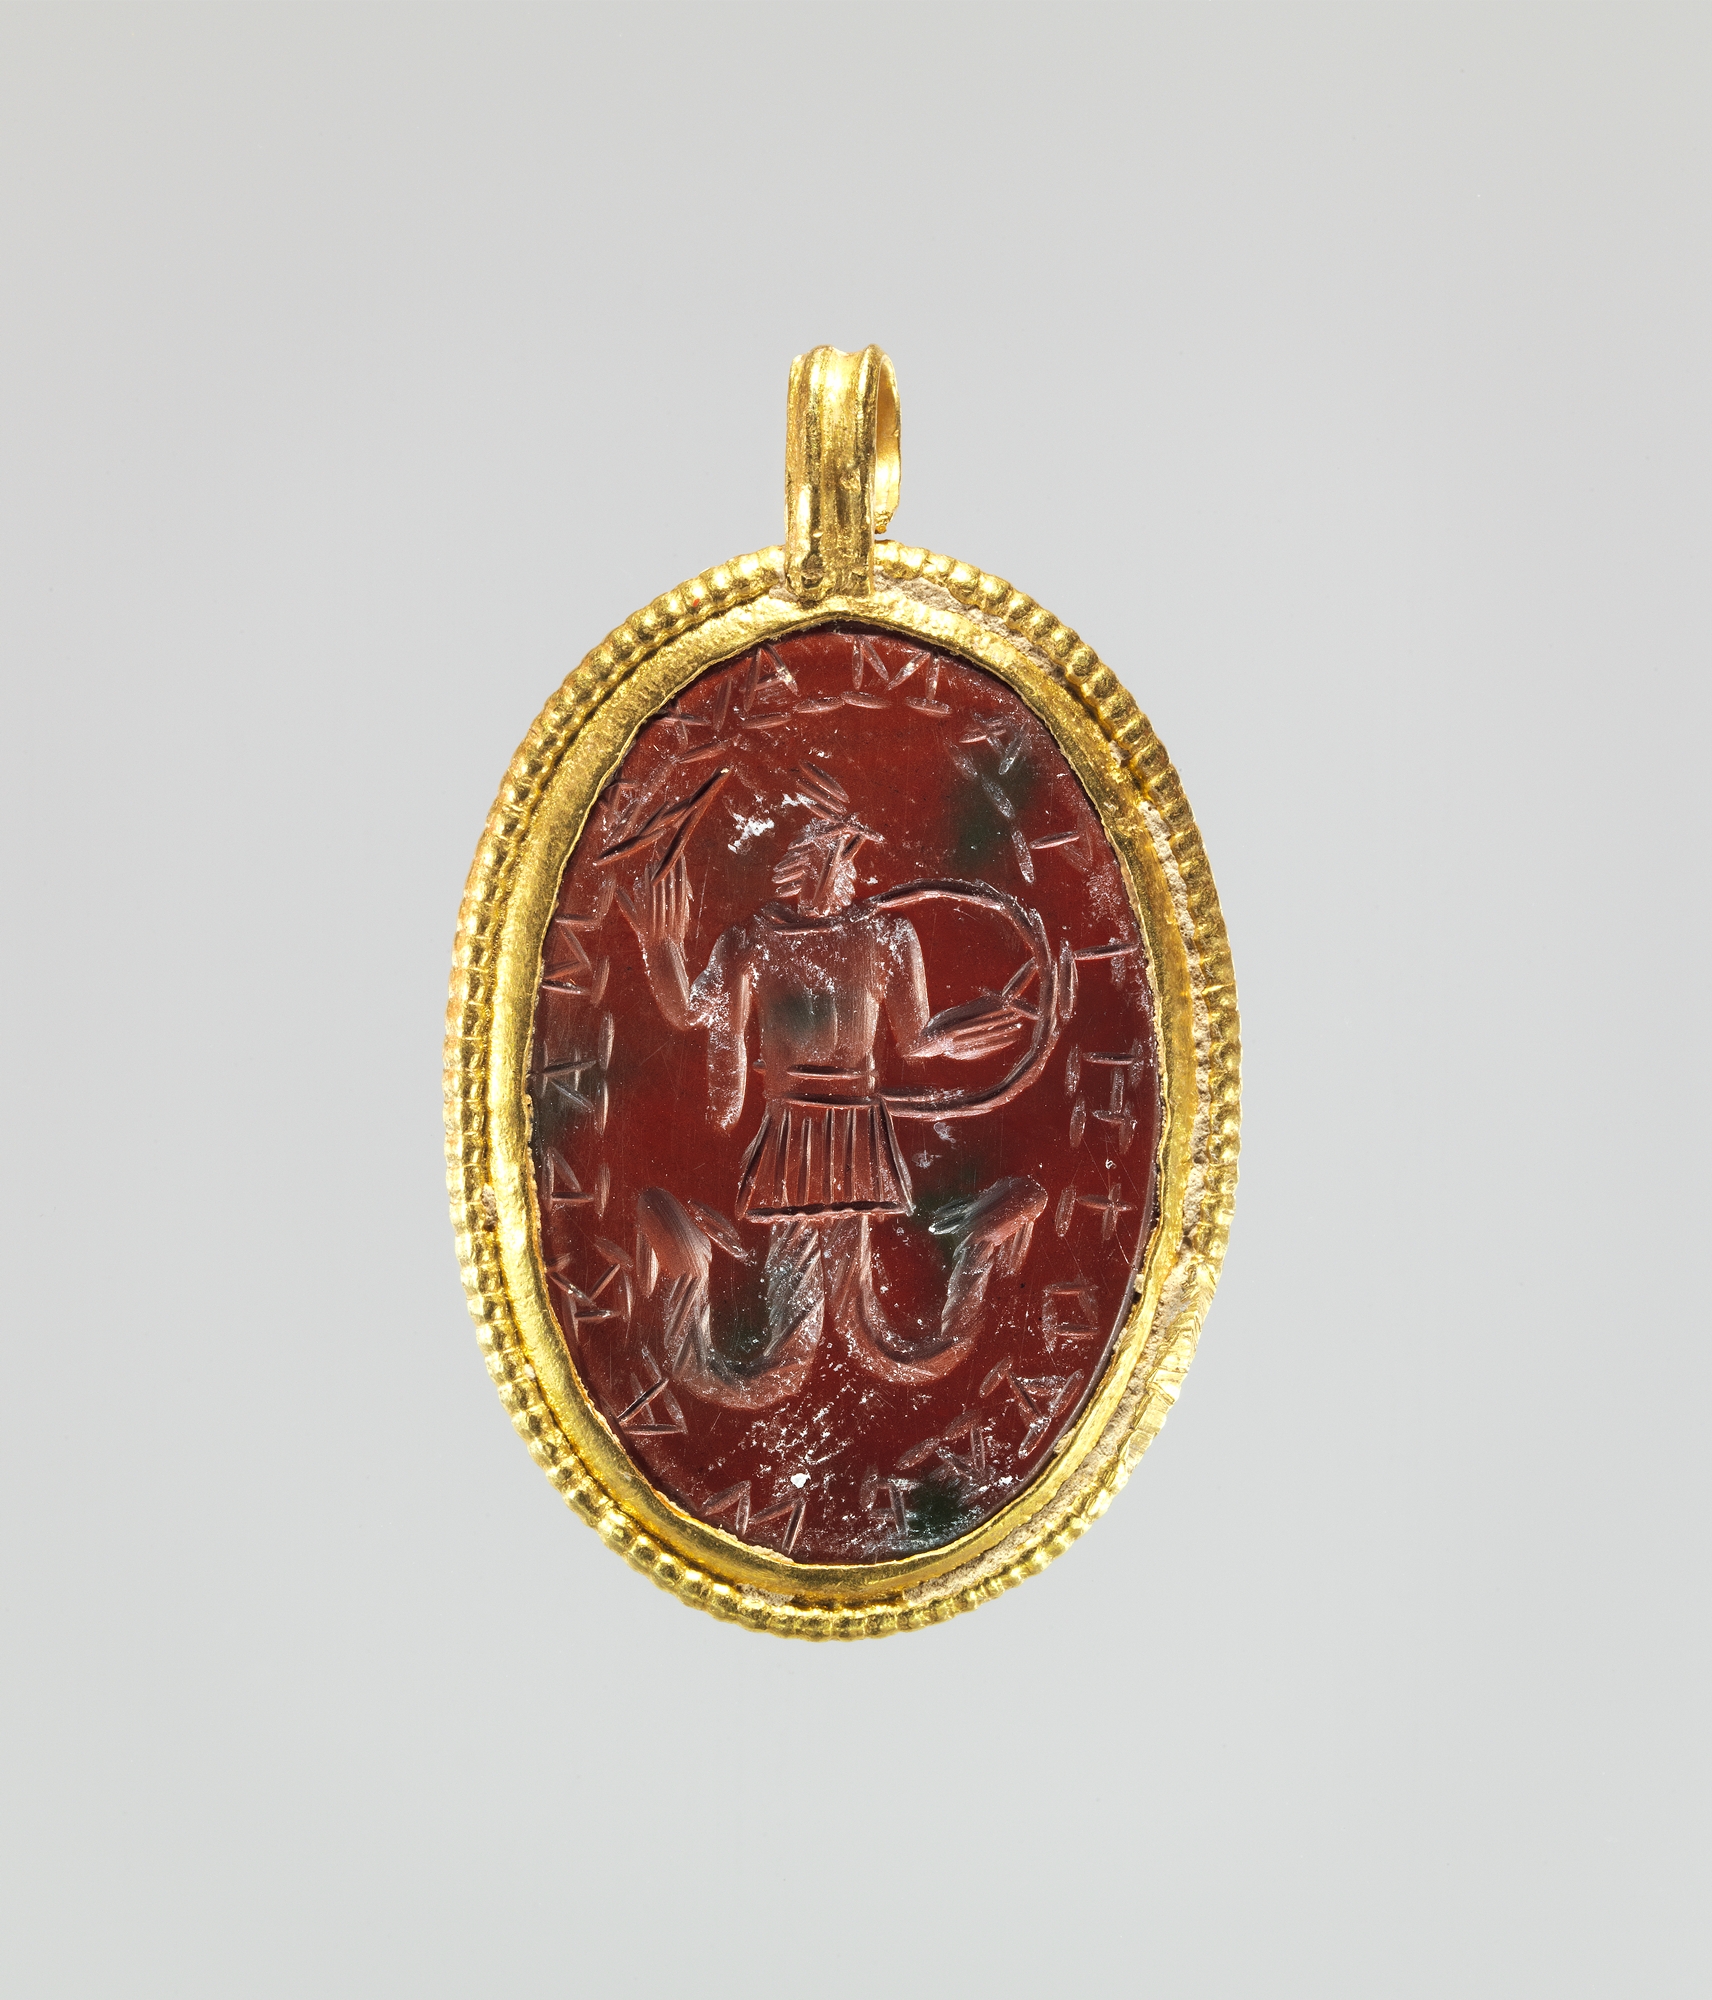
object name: intaglio, magical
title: Jasper intaglio: Cock-headed anguipede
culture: roman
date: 101-300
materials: gold, jasper